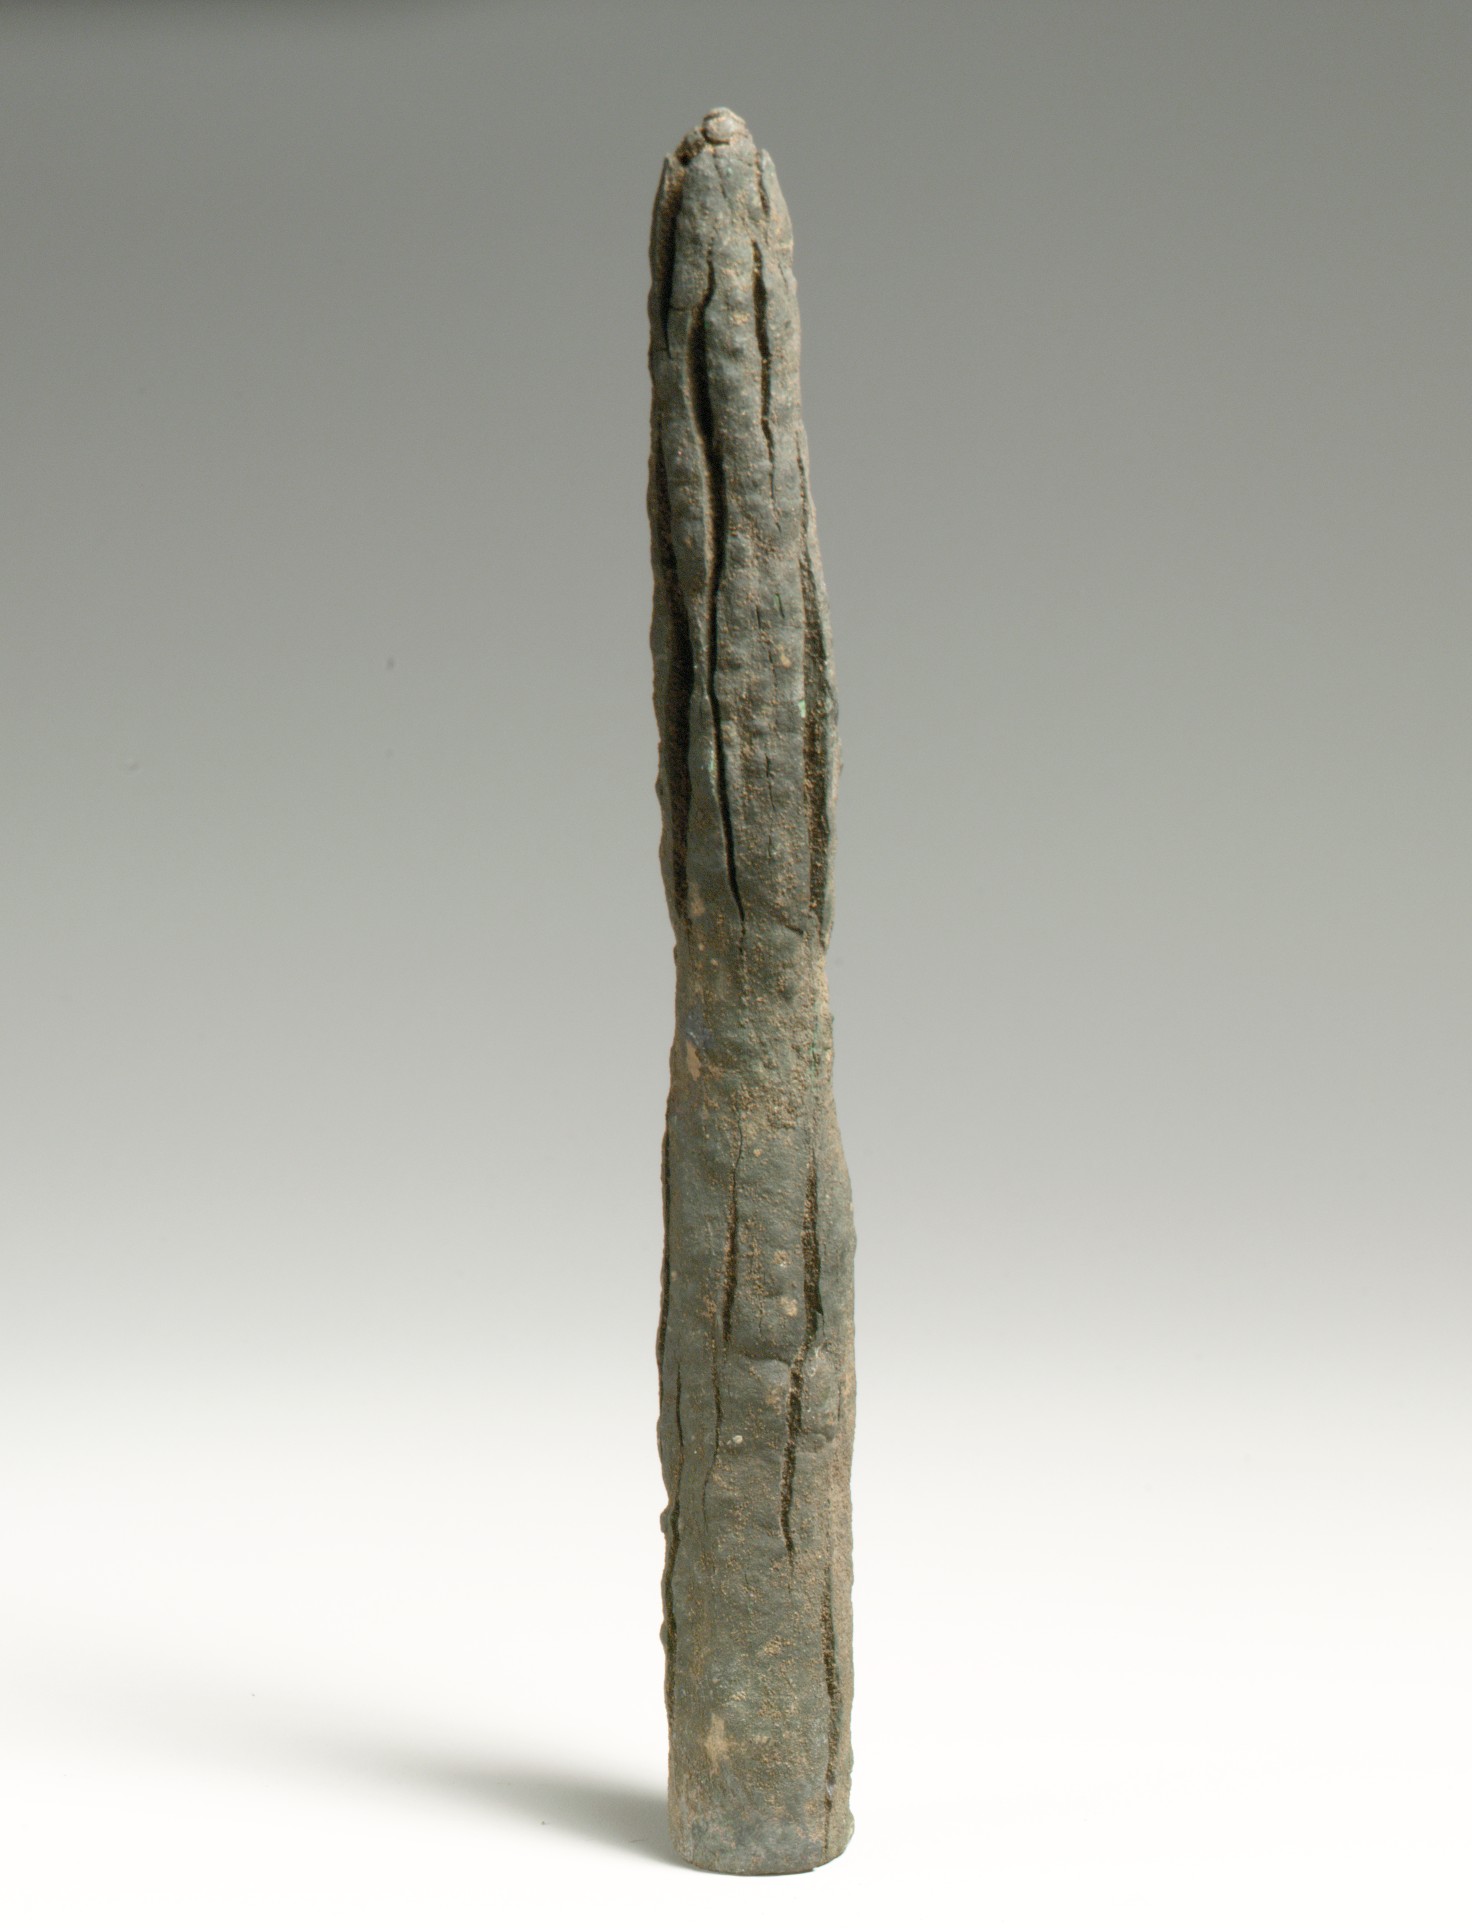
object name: spear butt, spike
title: Spear-butt, spike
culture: cypriot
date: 1050-1000 BCE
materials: bronze